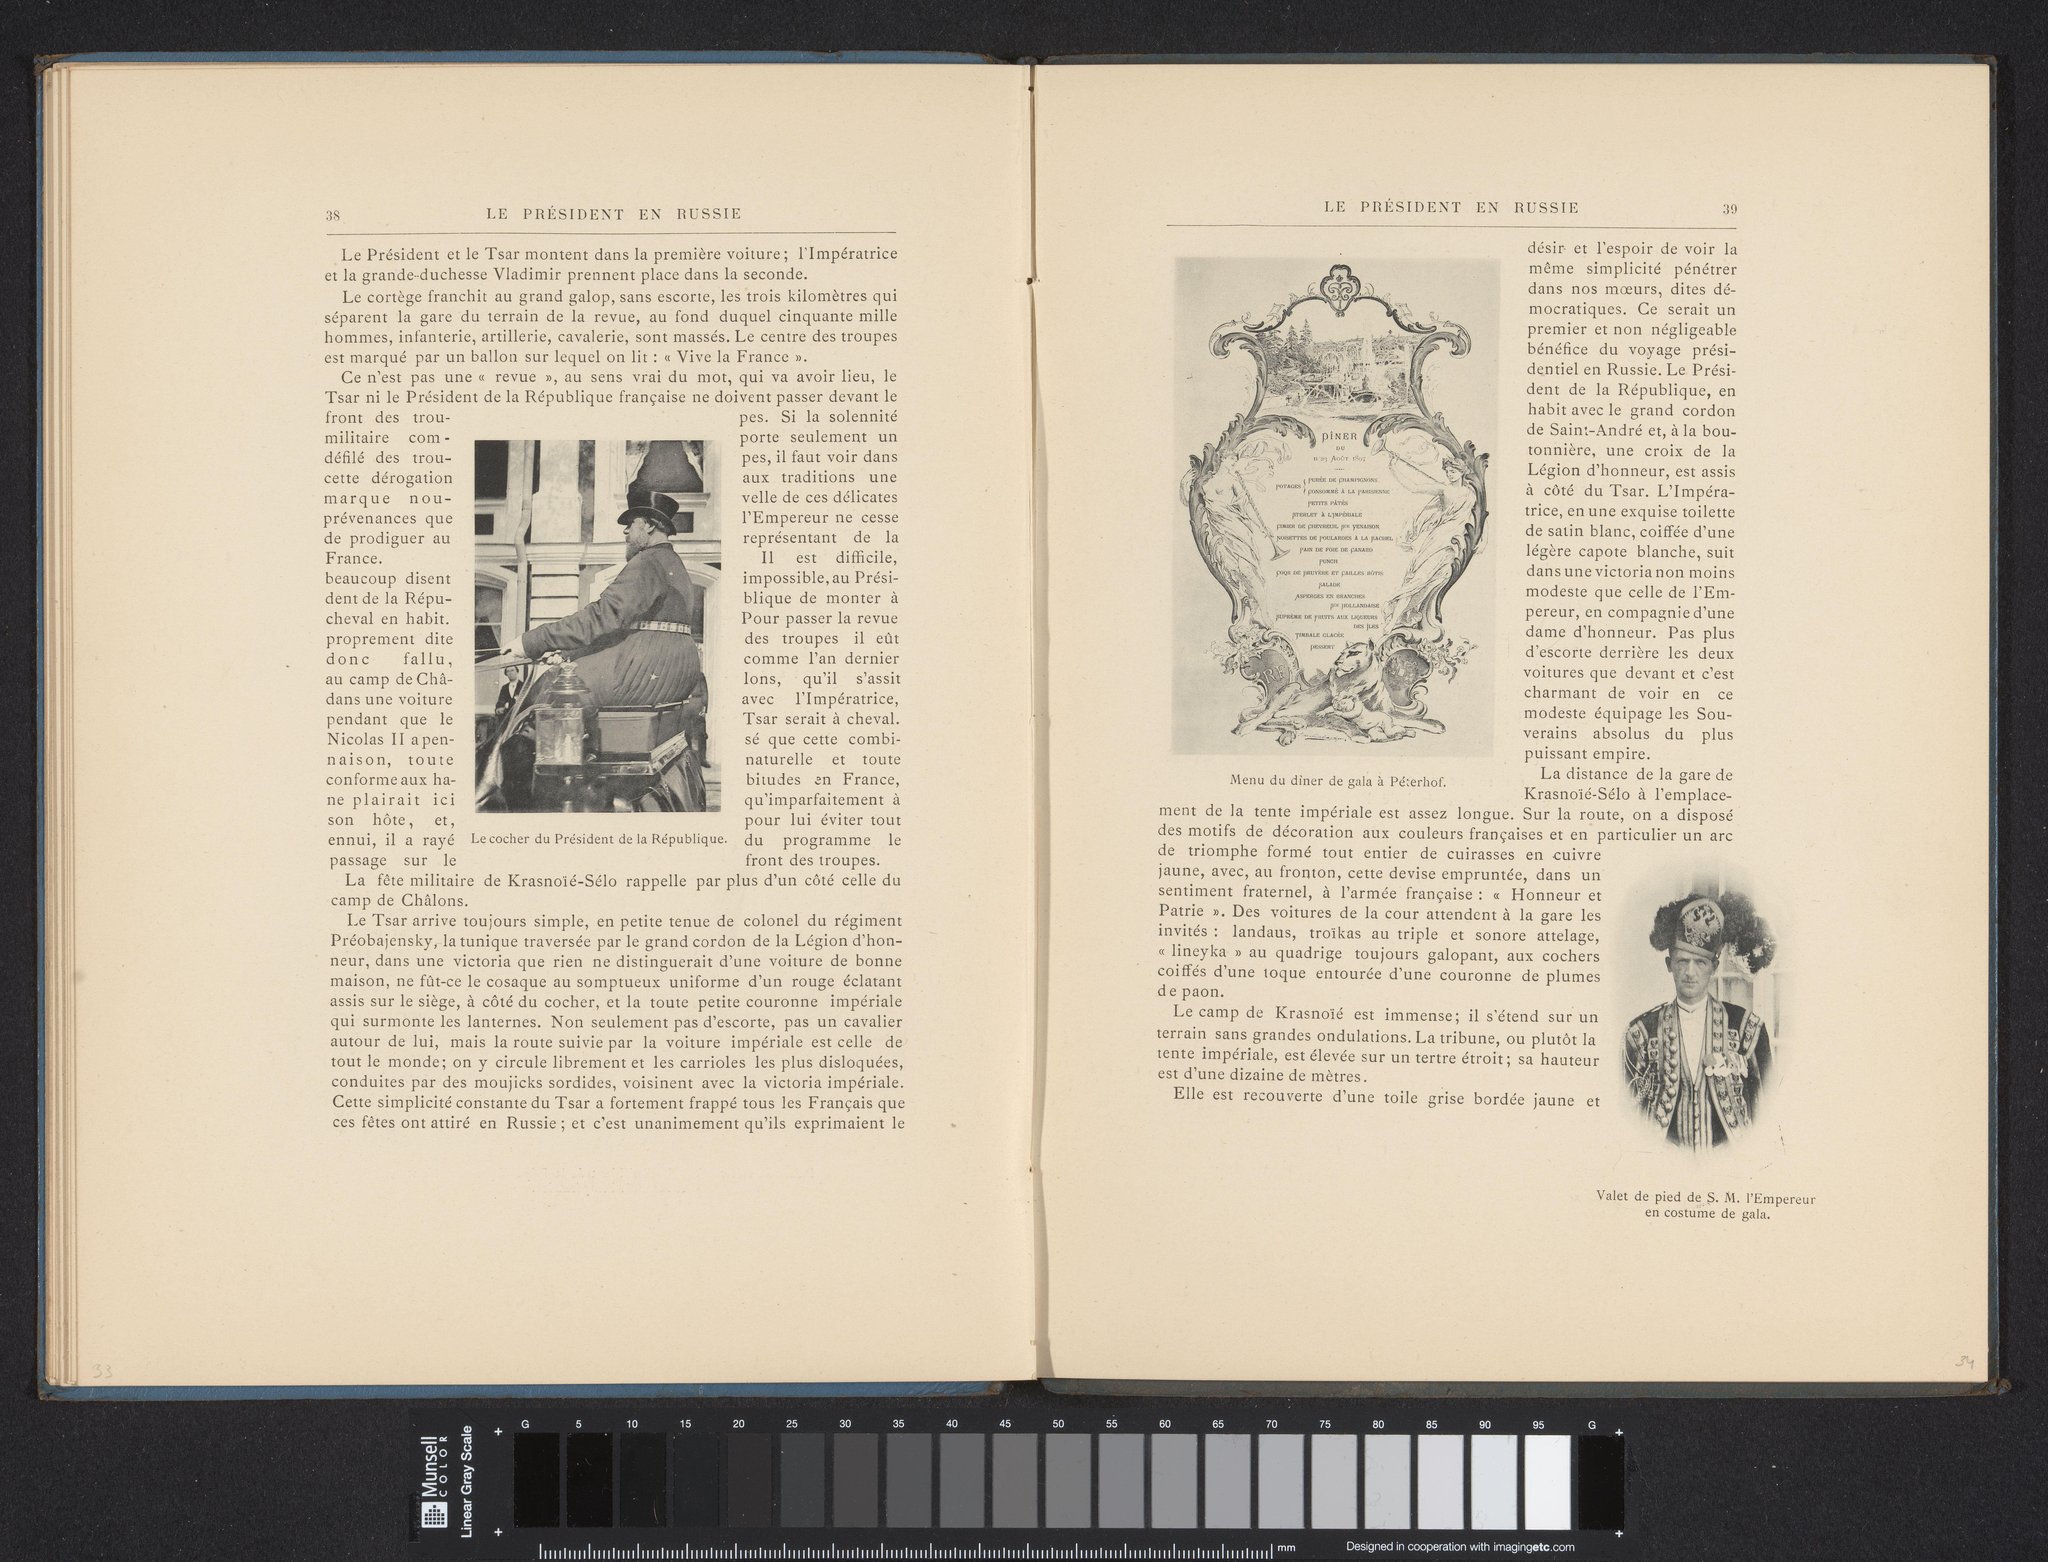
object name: page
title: Koetsier van president Félix Faure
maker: Anonymous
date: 1897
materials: paper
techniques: photograph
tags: four-wheeled vehicle drawn by one animal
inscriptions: inscription: ‘Le cocher du Président de la République.’